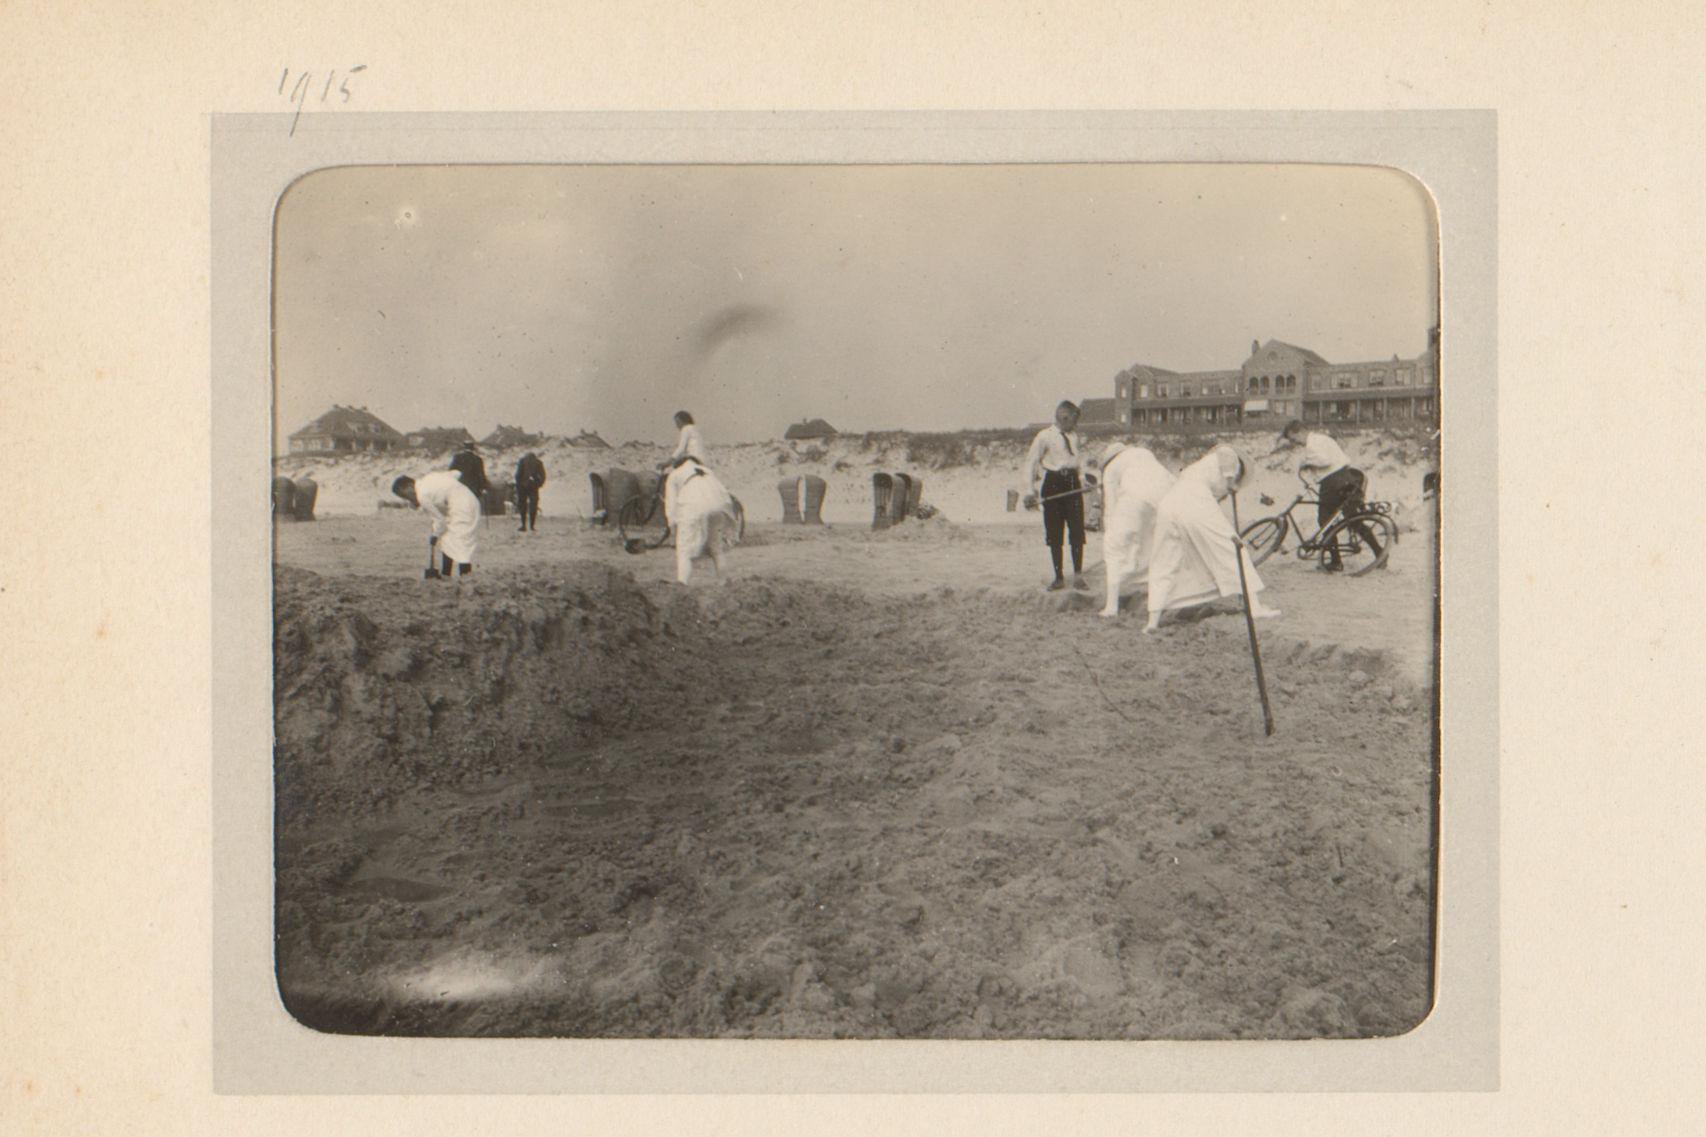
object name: photograph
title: Graafwerkzaamheden op het strand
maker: liesbeth overhoff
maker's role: fotograaf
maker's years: 1895-1969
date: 1915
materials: paper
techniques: gelatin silver print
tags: historical persons, digging (industrial process), beach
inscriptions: inscription: ‘1915’